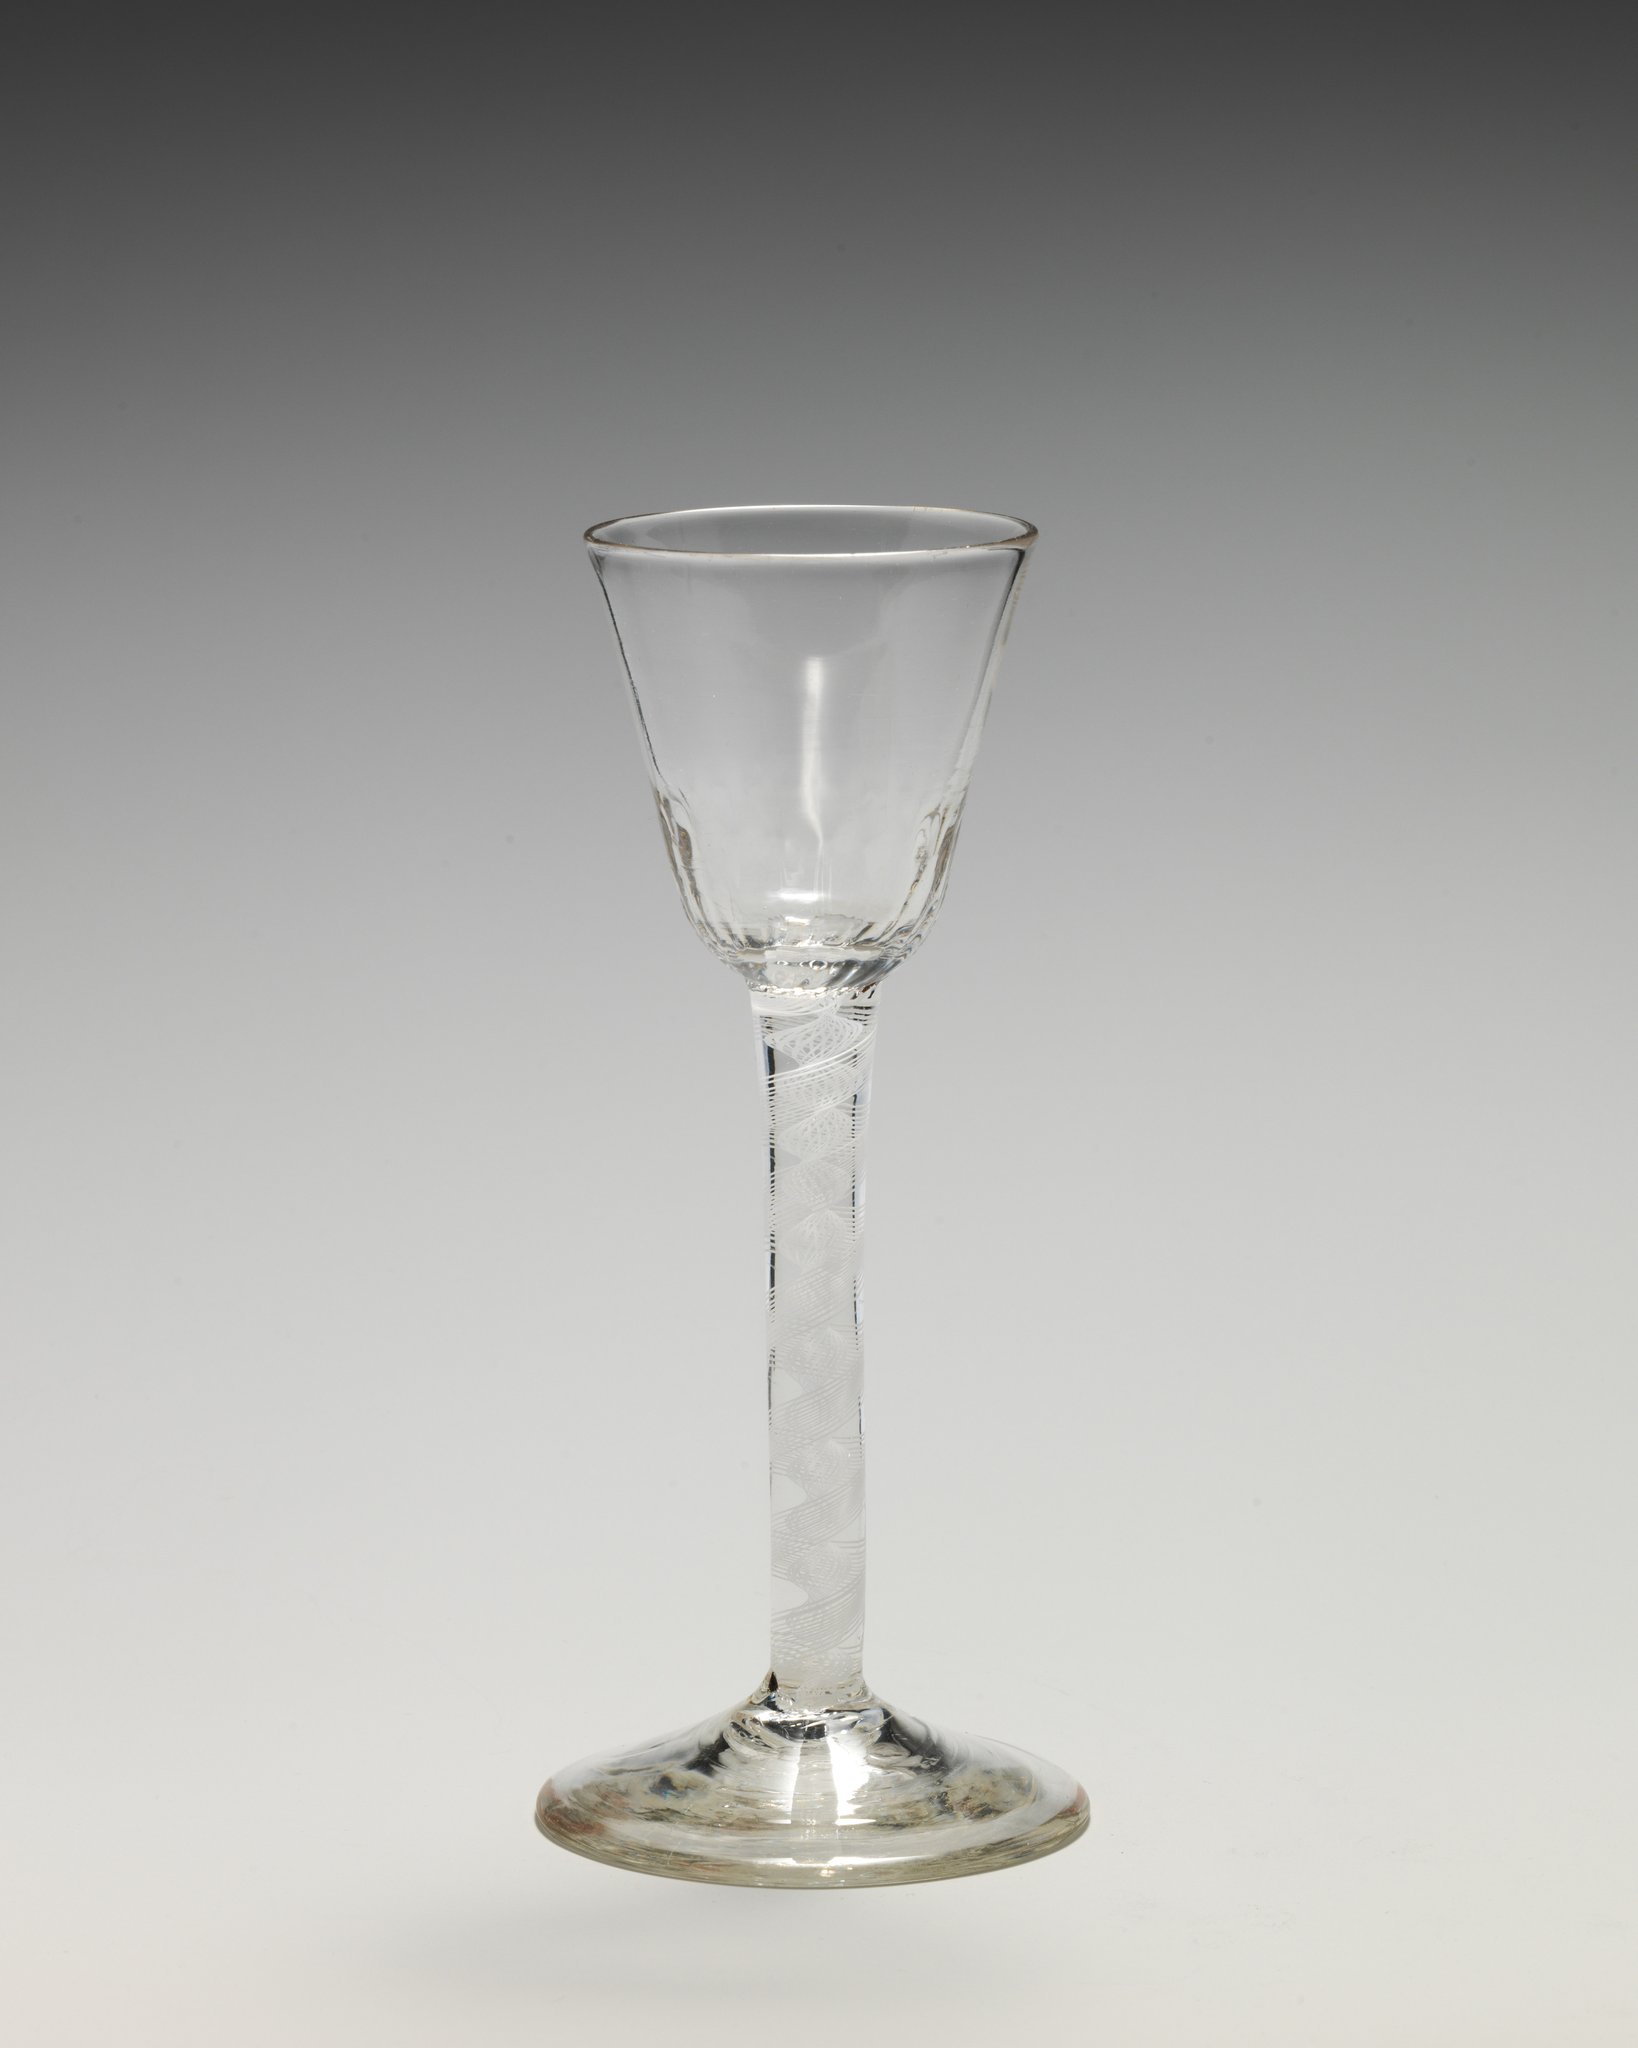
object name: wineglass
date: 1767-1800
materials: glass